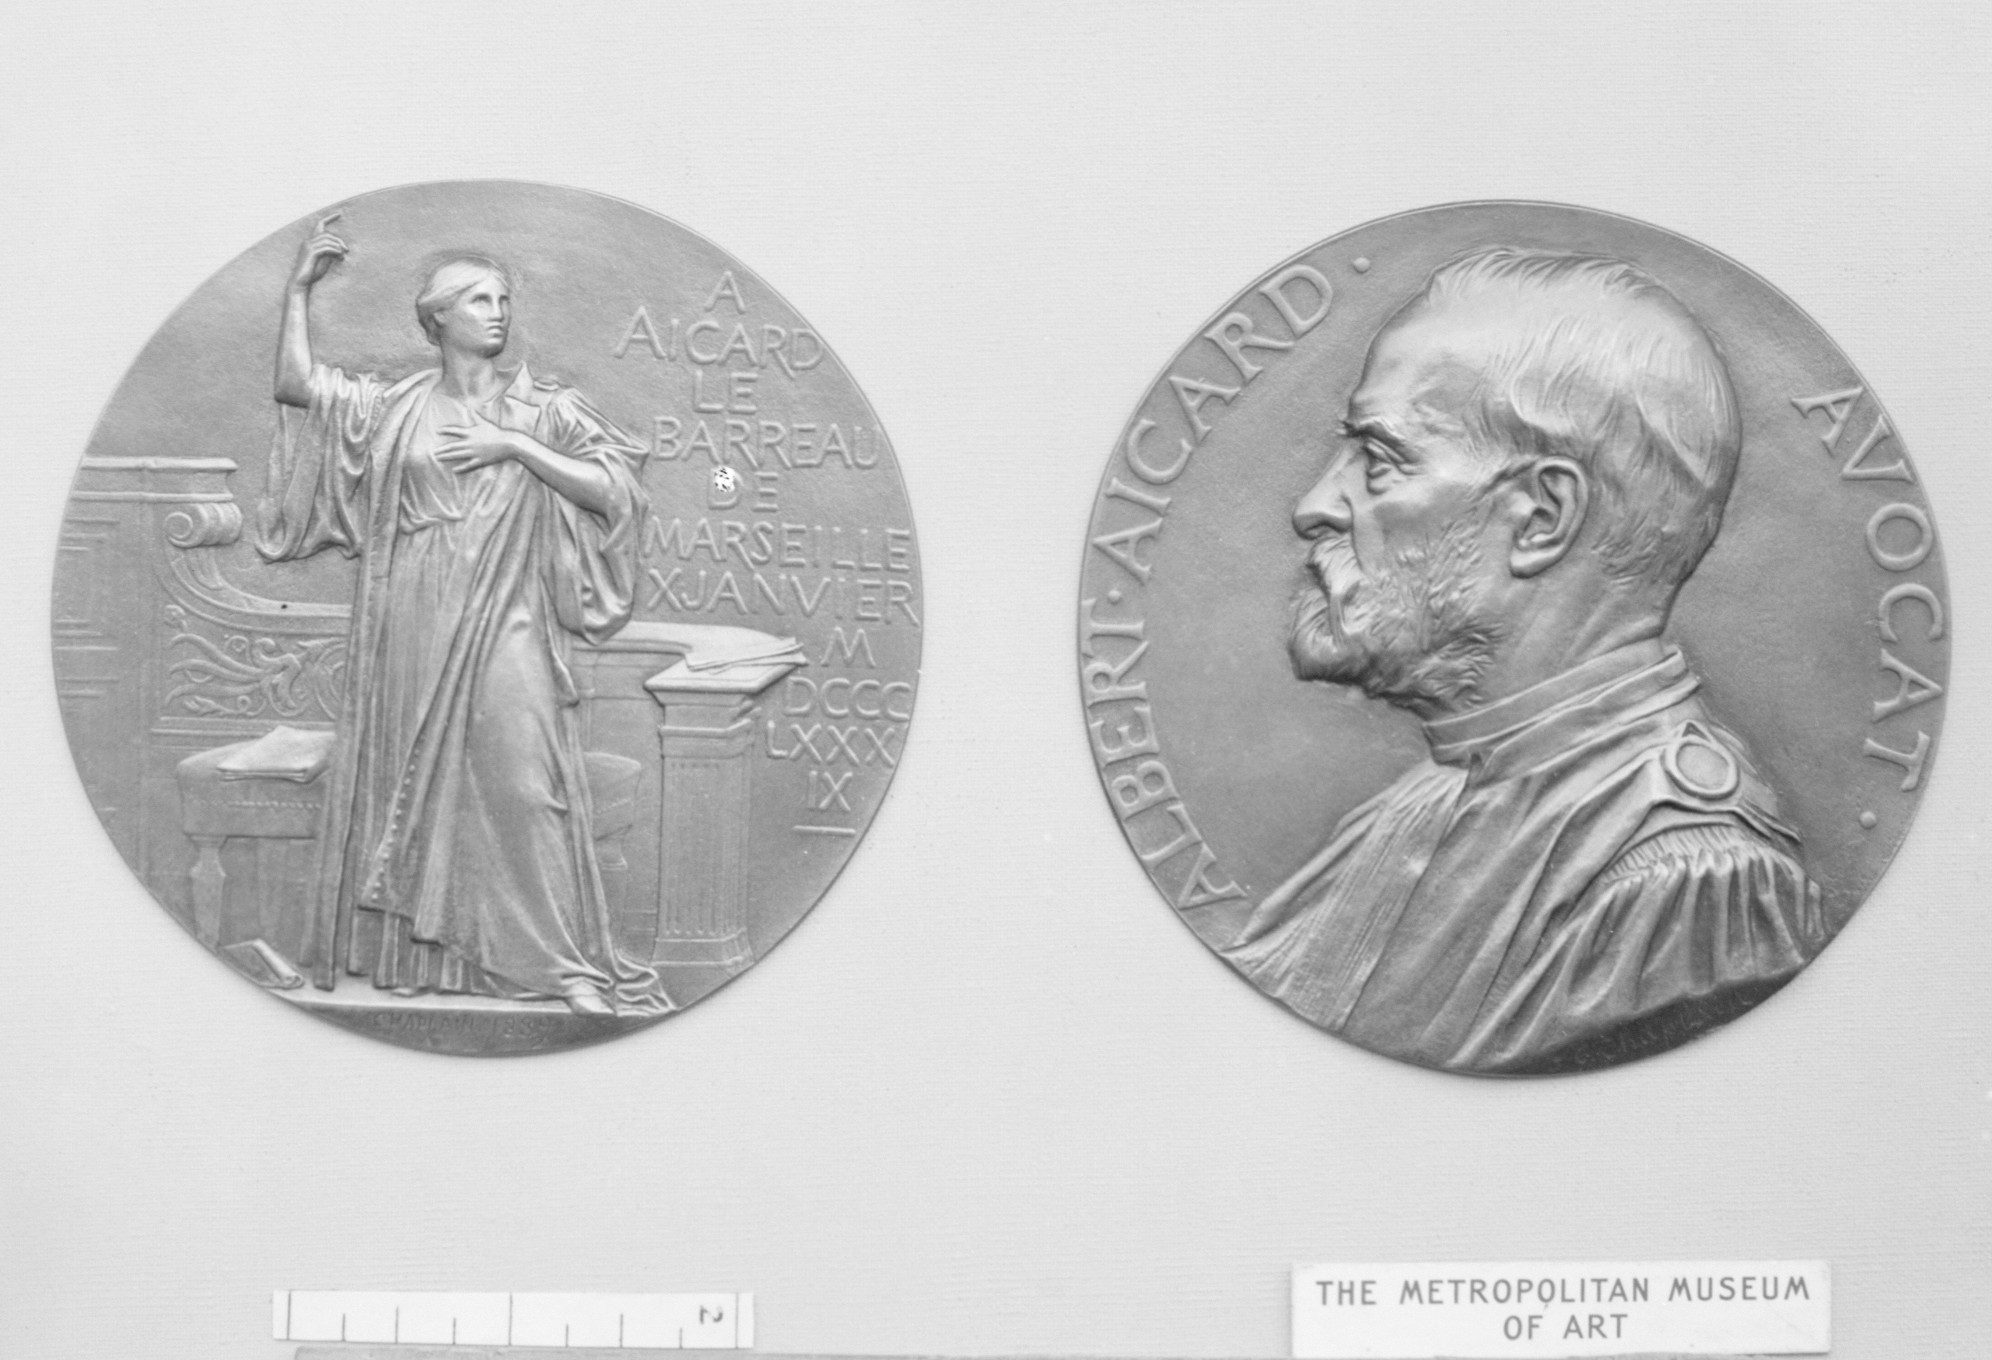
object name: medal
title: In honor of M. Aicard, Advocate, 1889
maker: jules-clément chaplain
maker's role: artist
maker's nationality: french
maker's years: 1839-1909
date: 1889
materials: bronze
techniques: casting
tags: men,profiles,women